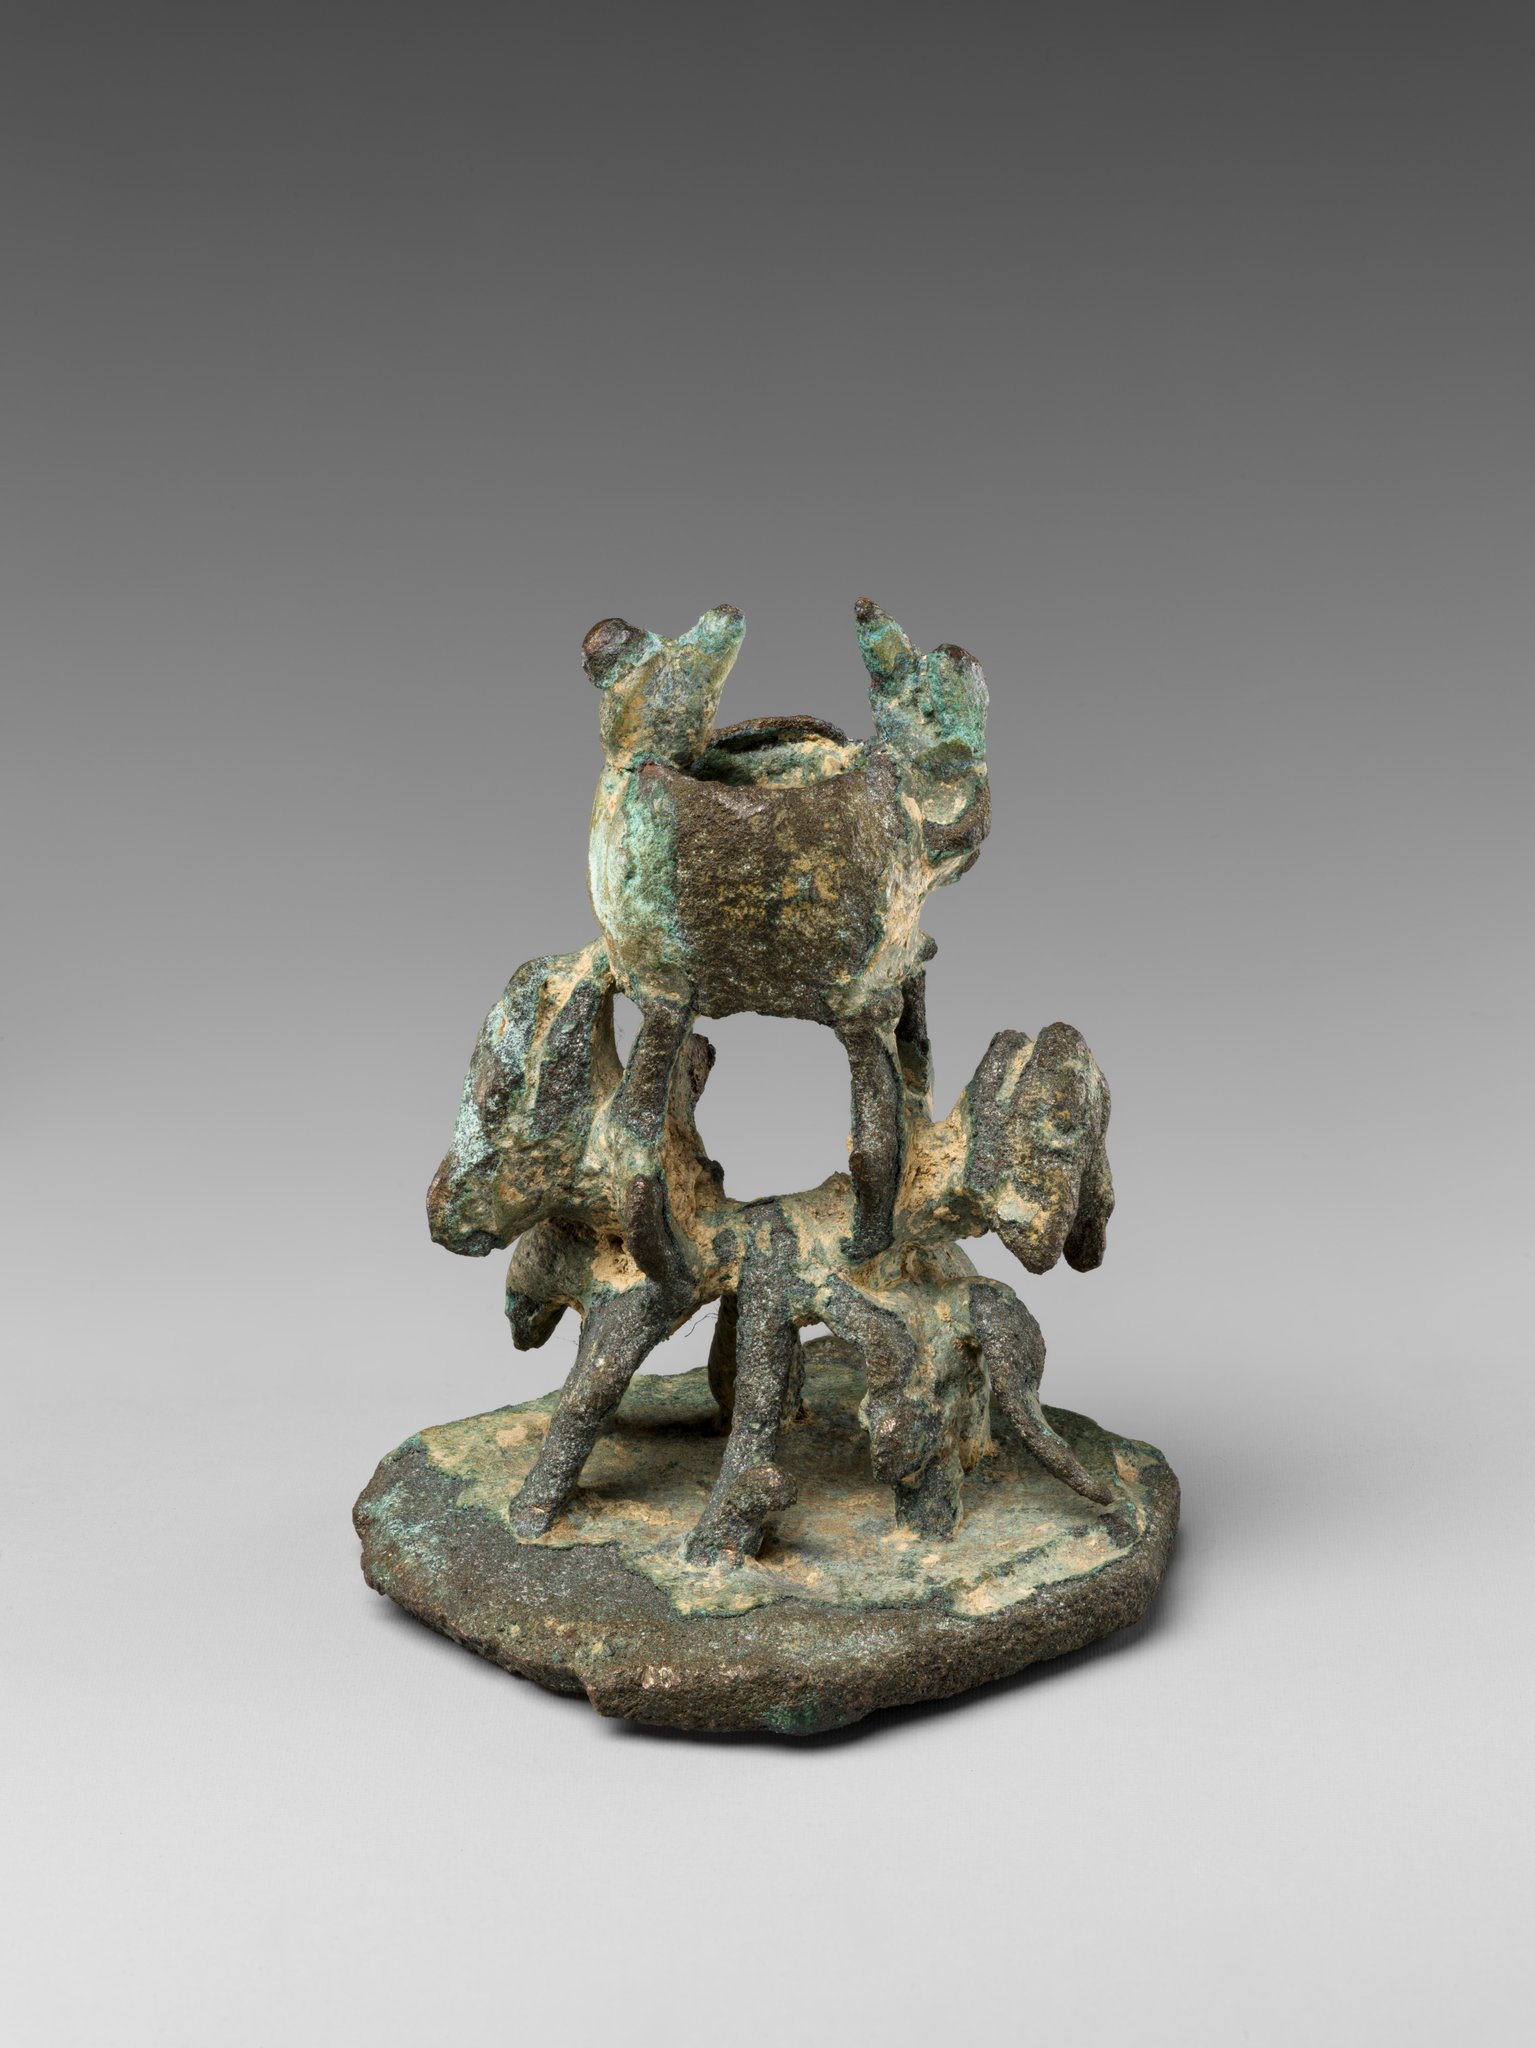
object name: seal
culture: korean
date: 918-1392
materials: bronze